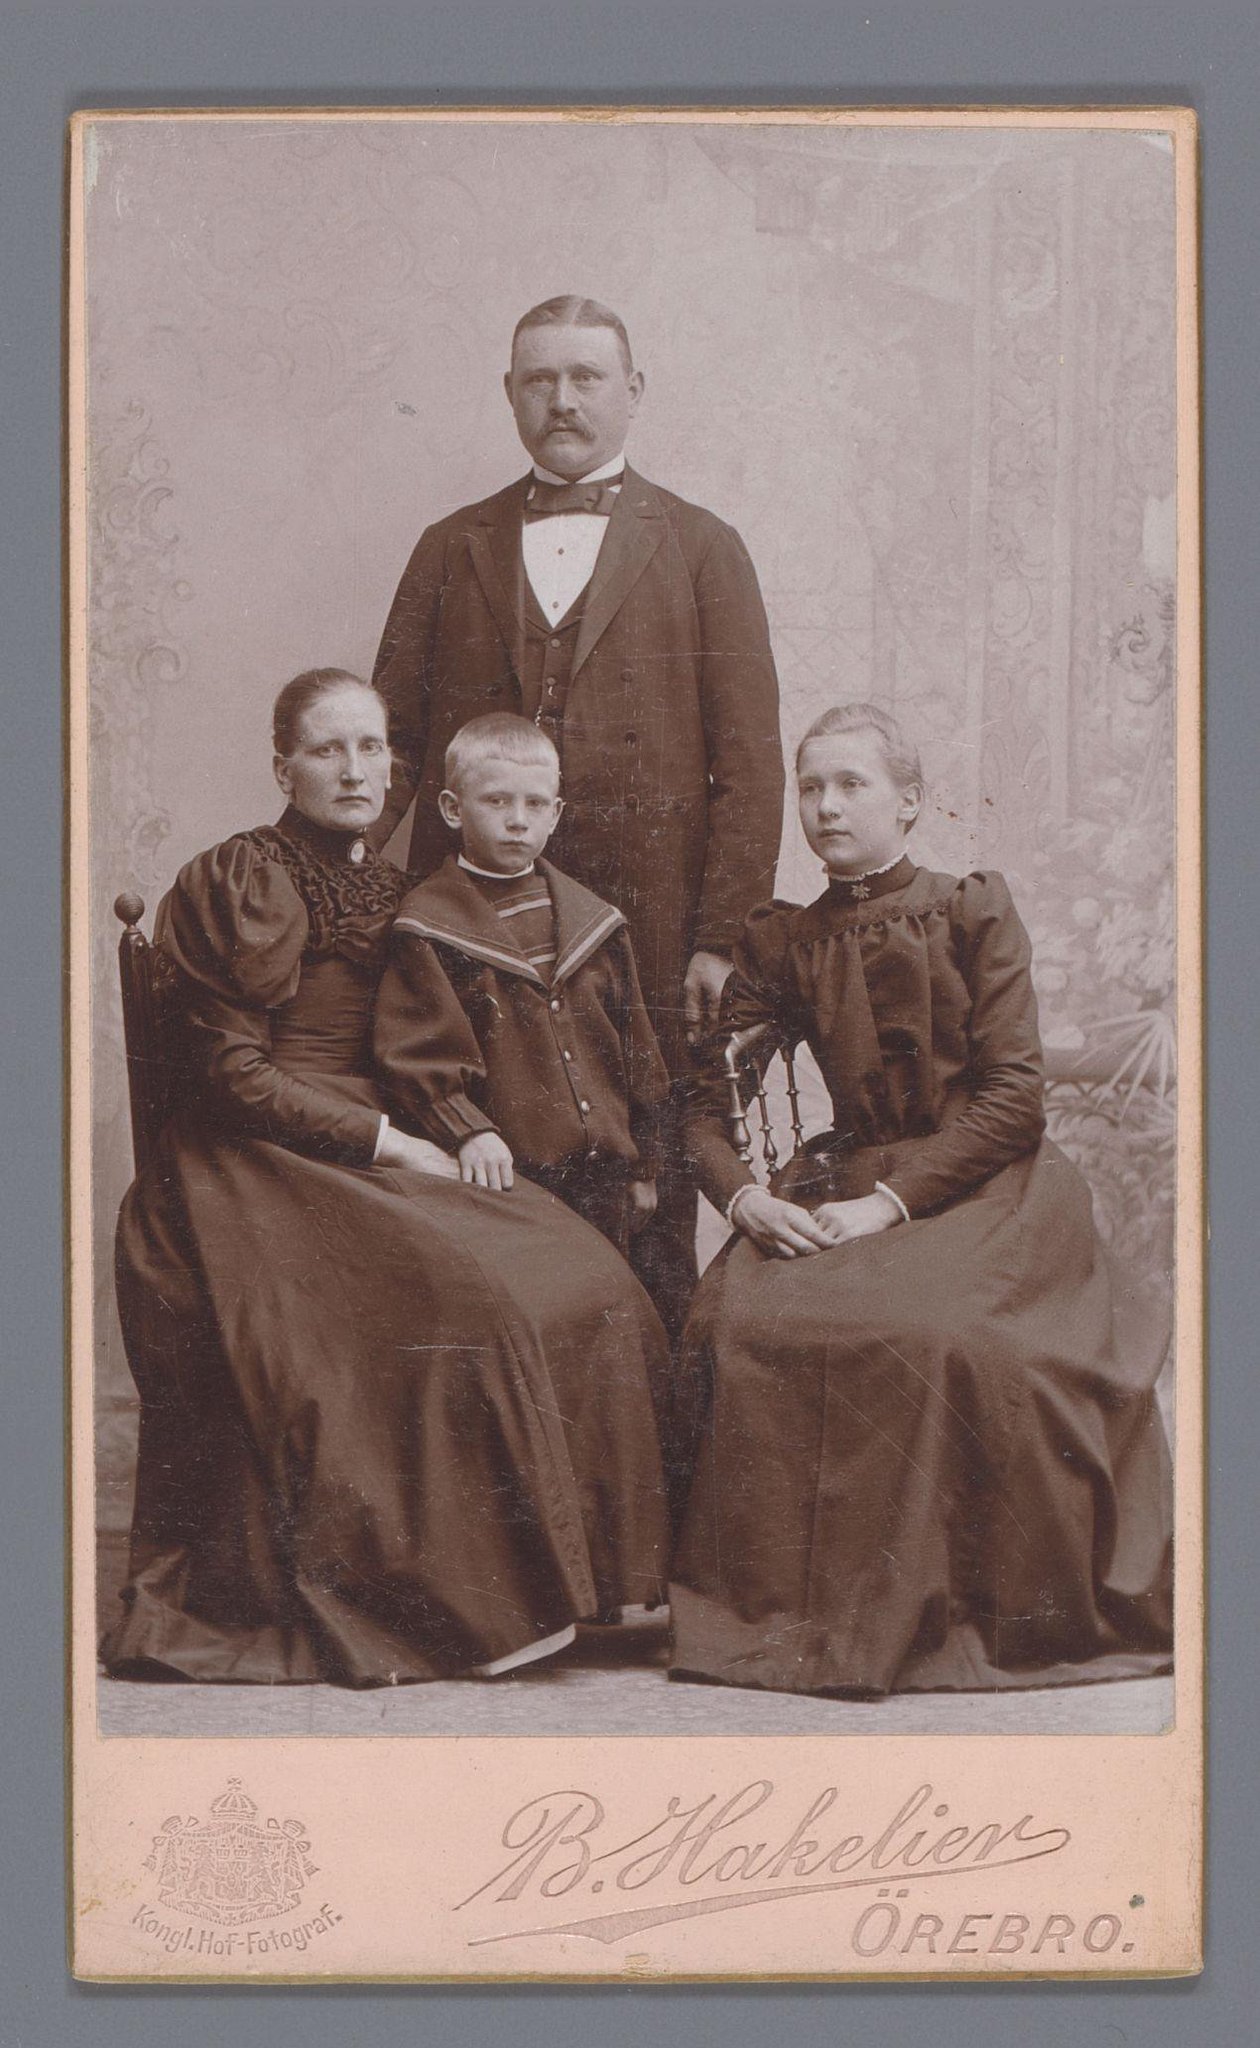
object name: photograph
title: Groepsportret van een onbekende familie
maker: bernhard hakelier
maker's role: fotograaf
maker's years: 1848-1910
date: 1883-1910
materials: cardboard, photographic support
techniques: daylight paper print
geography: orebro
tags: family group, especially parents with their child(ren)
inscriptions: check stamp: ‘Kongl. Hof-Fotograf.’, inscription: ‘KONGL. HOF-FOTOGRAF/ (...) 1883 (...)/ Bernhard Hakelier/ Örebro/ Plåten förvaras för efterbeställning’